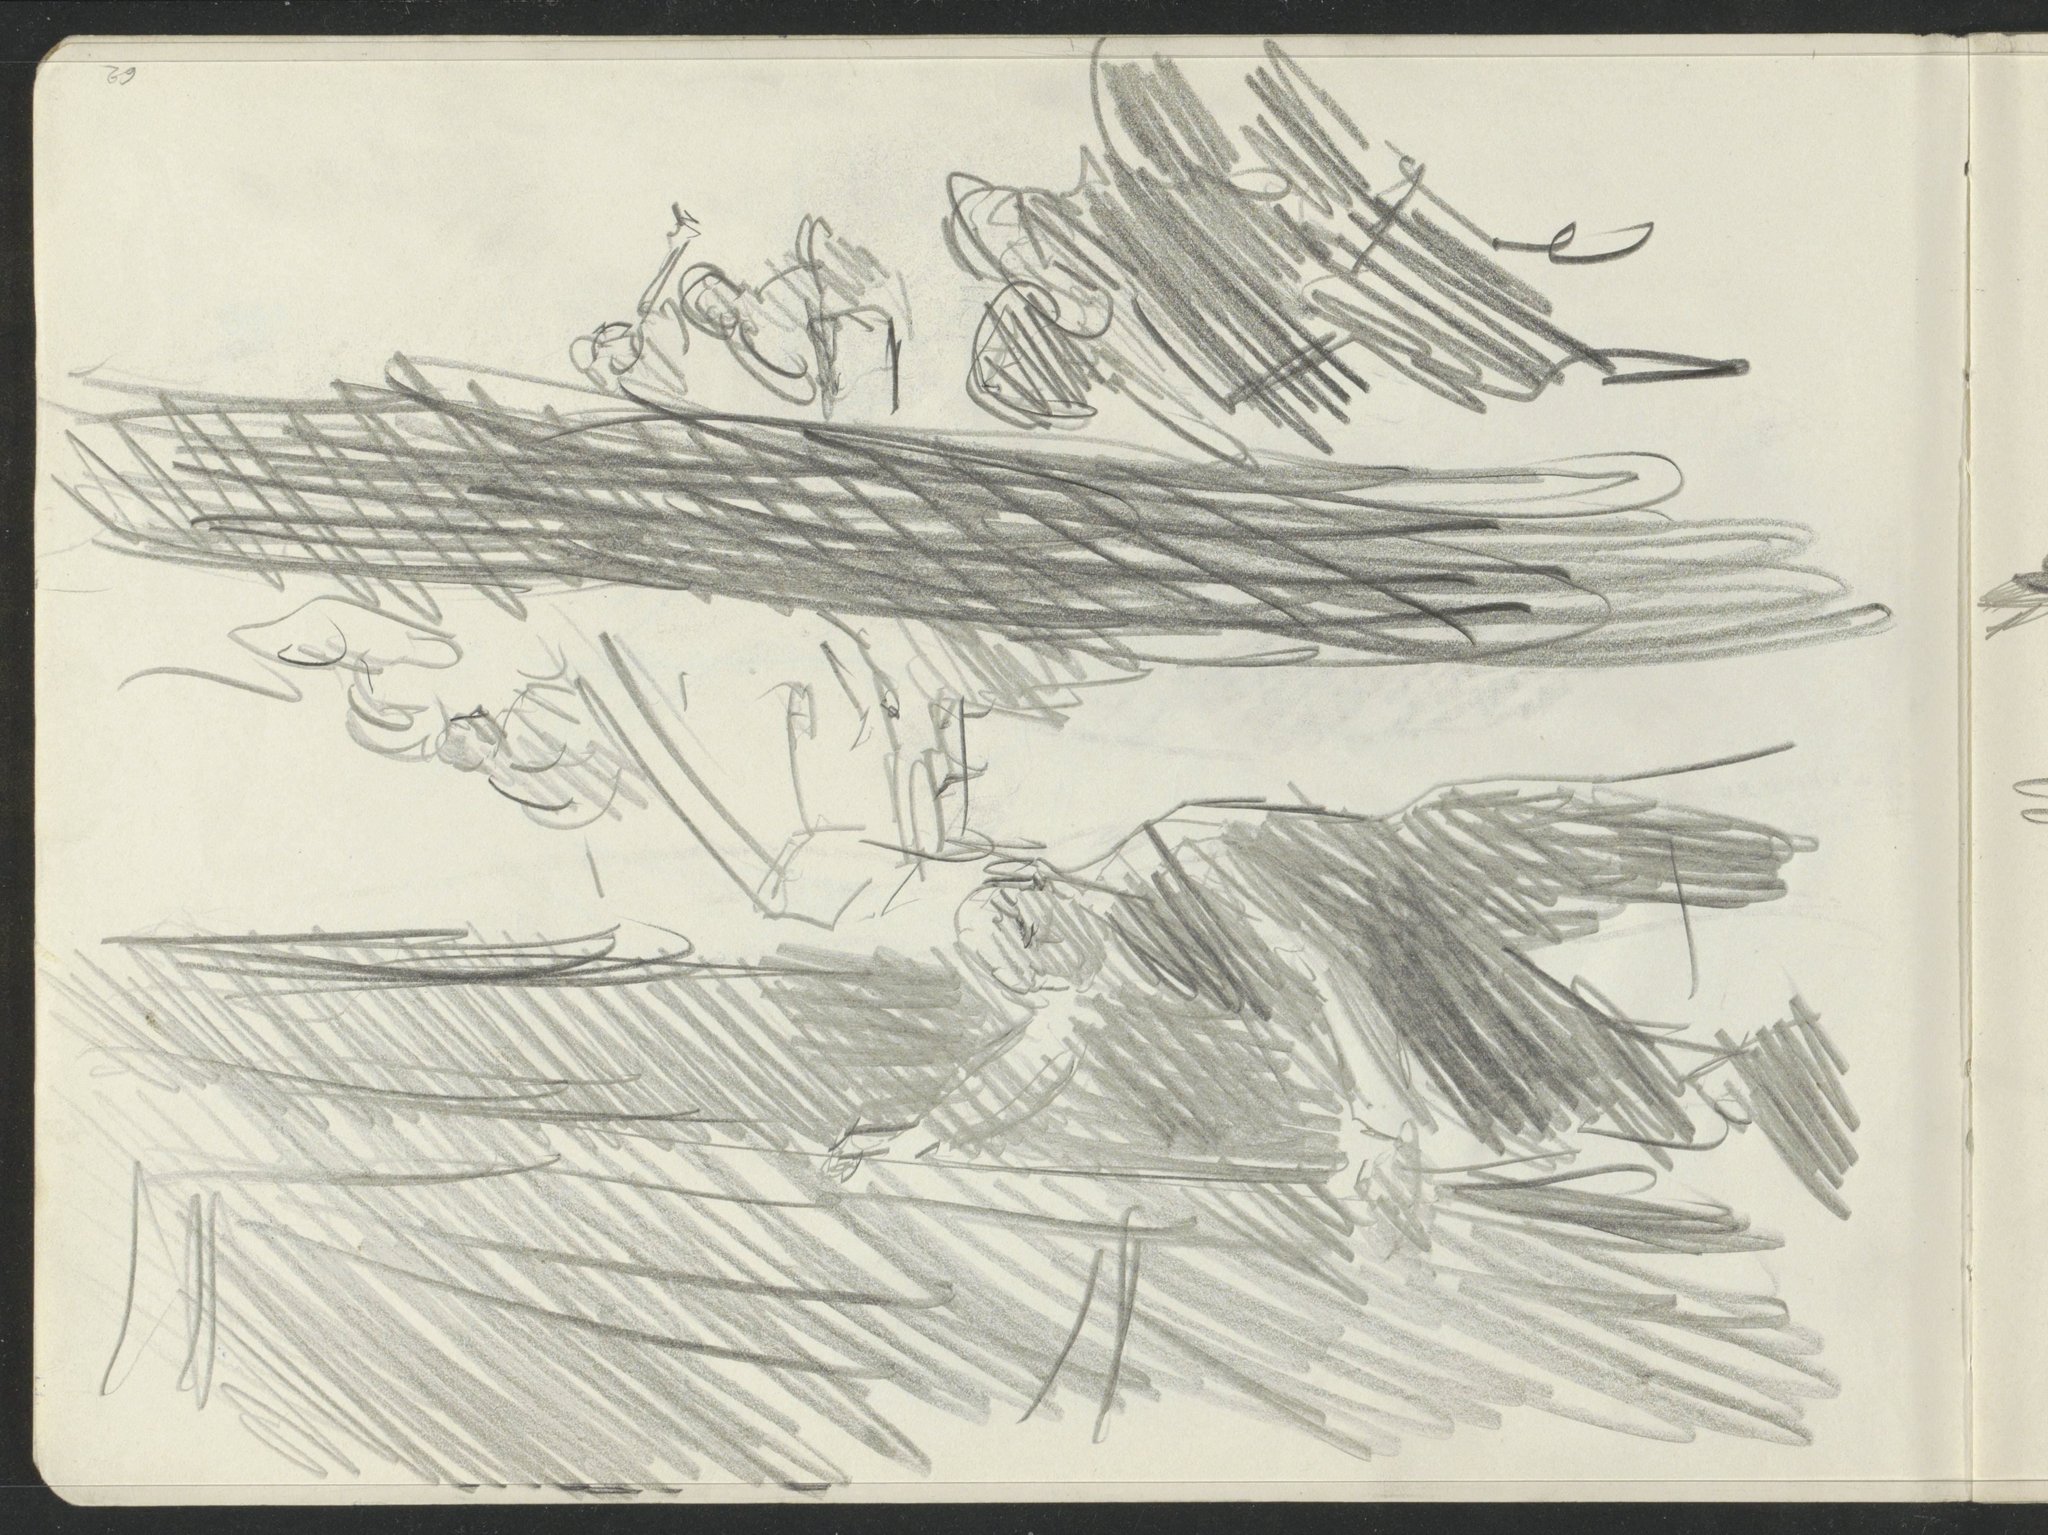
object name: sketchbook leaf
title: Figuren tussen coulissen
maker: isaac israels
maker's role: draughtsman, painter, print maker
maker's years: 1865-1934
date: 1915-1934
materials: paper, pencil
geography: the hague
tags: grand piano, adult man, the stage and its equipment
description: Op de achtergrond een piano en figuren op het toneel. Blad 1 verso uit schetsboek XVII met 31 bladen.